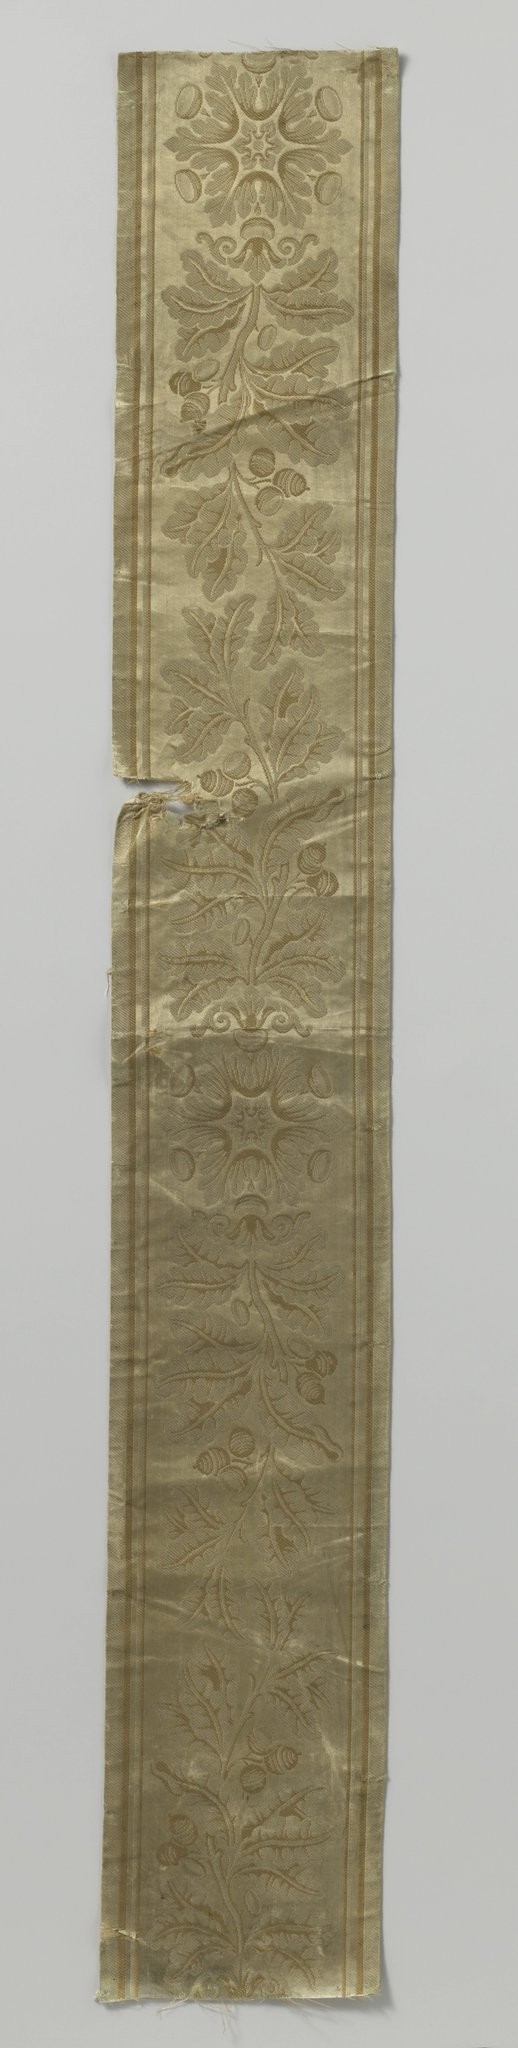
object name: upholstered wall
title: Fragment van een wandbespanning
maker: Anonymous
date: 1825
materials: silk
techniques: lampas, weave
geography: europe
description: Een rand van zijden wandbespanning in zijden lampas. Op lichtblauwe fond staan, in beige en wit, zesbladerige rozetten, waaraan een opgaande en een neergaande eiketak met eikels. Rechte lijsten links en rechts. Opmerking: Zelfkant; 3 mm, effenbinding.